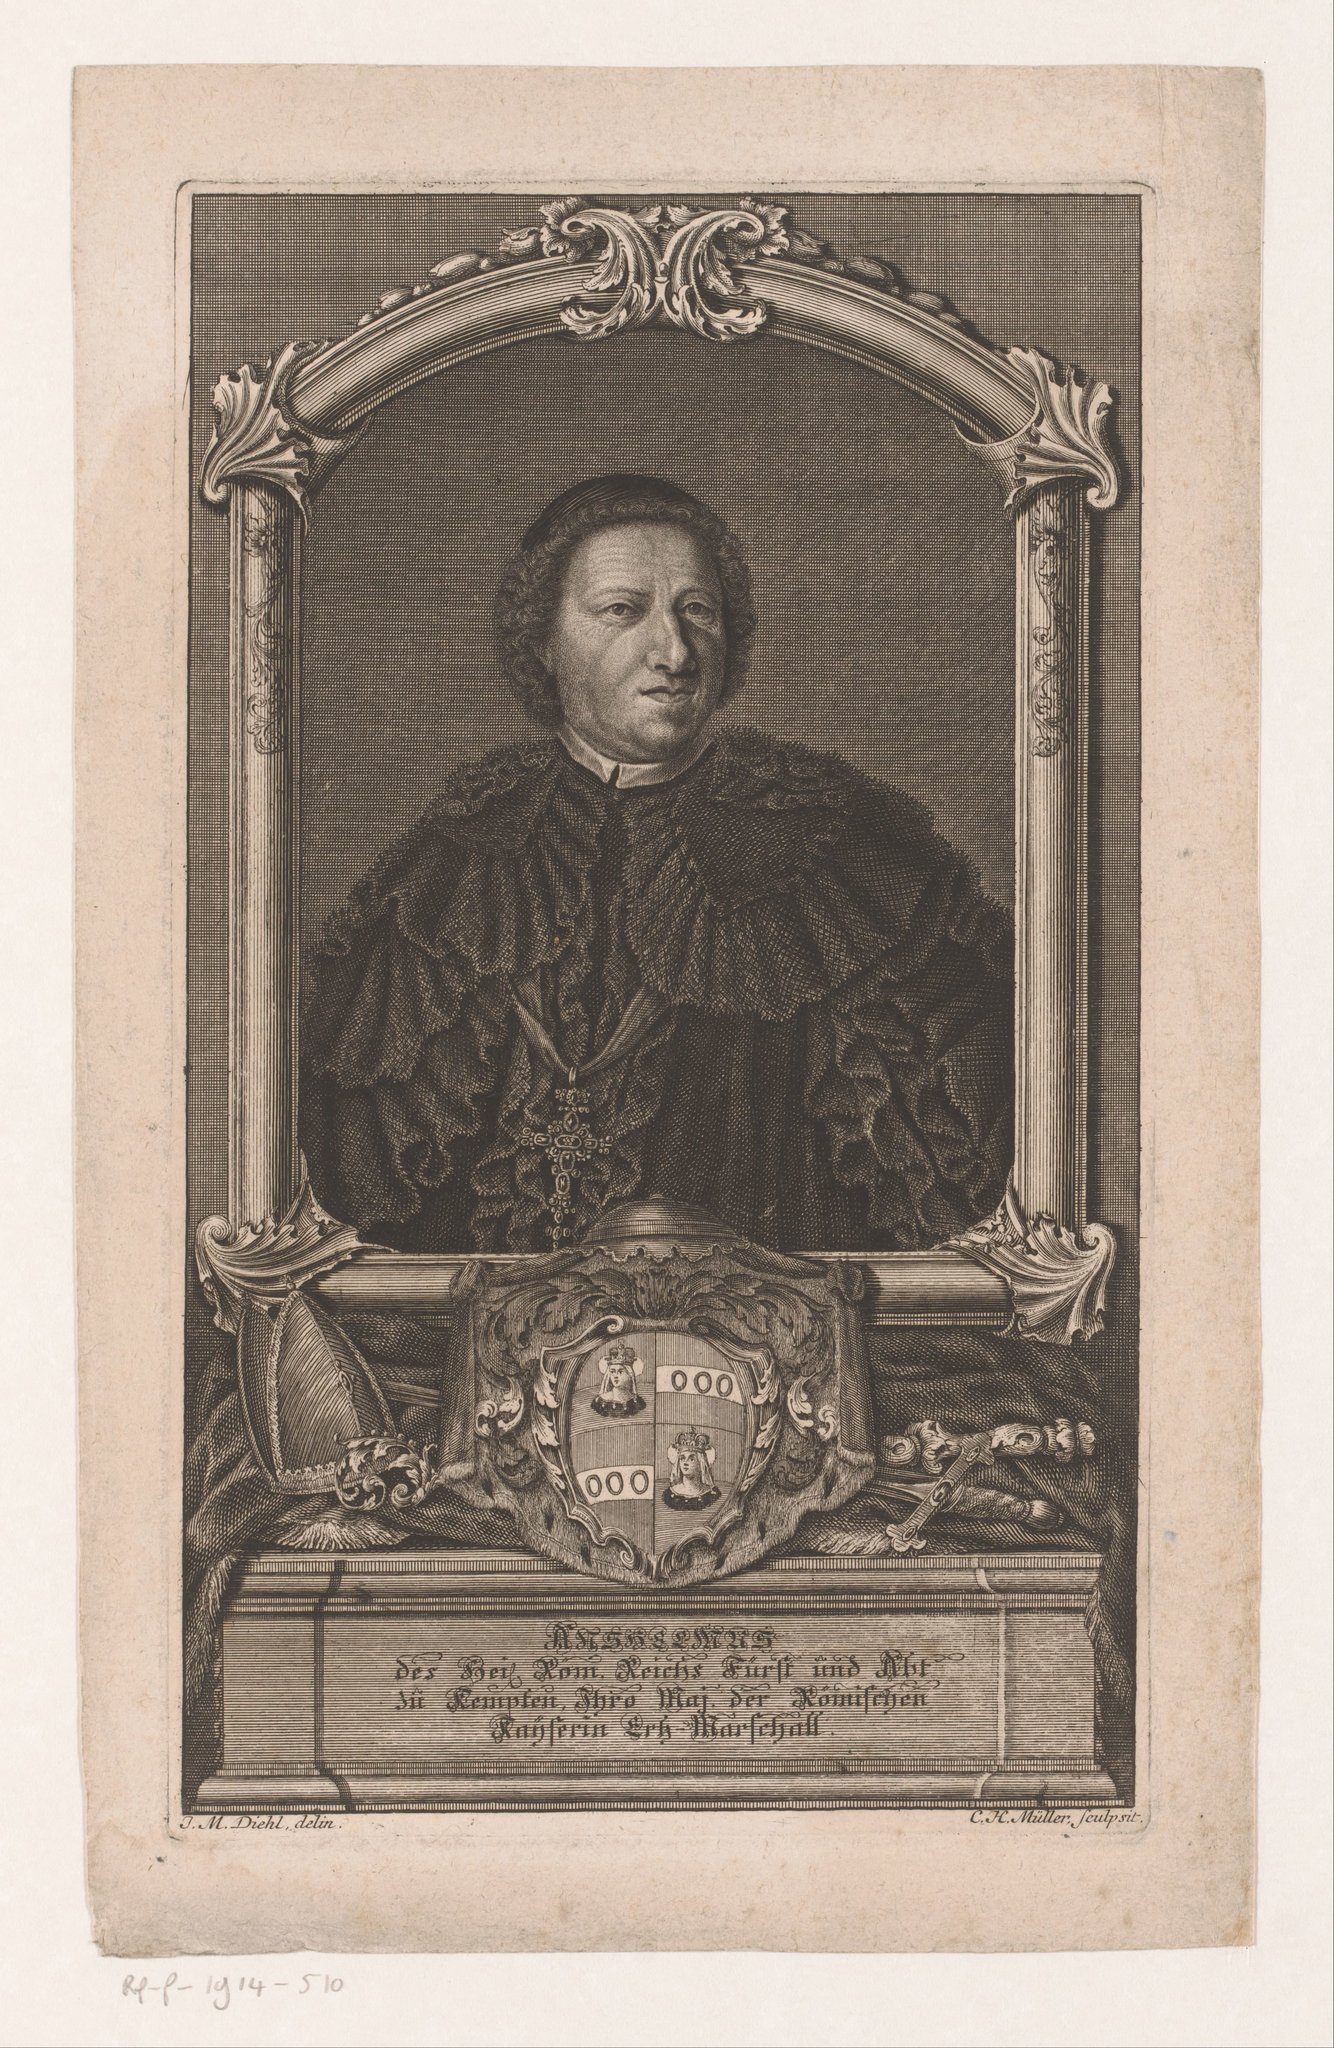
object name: print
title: Portret van Anselm Reichlin von Meldegg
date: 1728-1799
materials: paper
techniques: engraving, etching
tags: liturgical vestments, canonicals, theologian, historical persons, crucifix ~ personal devotion, armorial bearing, heraldry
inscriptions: collector's mark: Lugt 2228